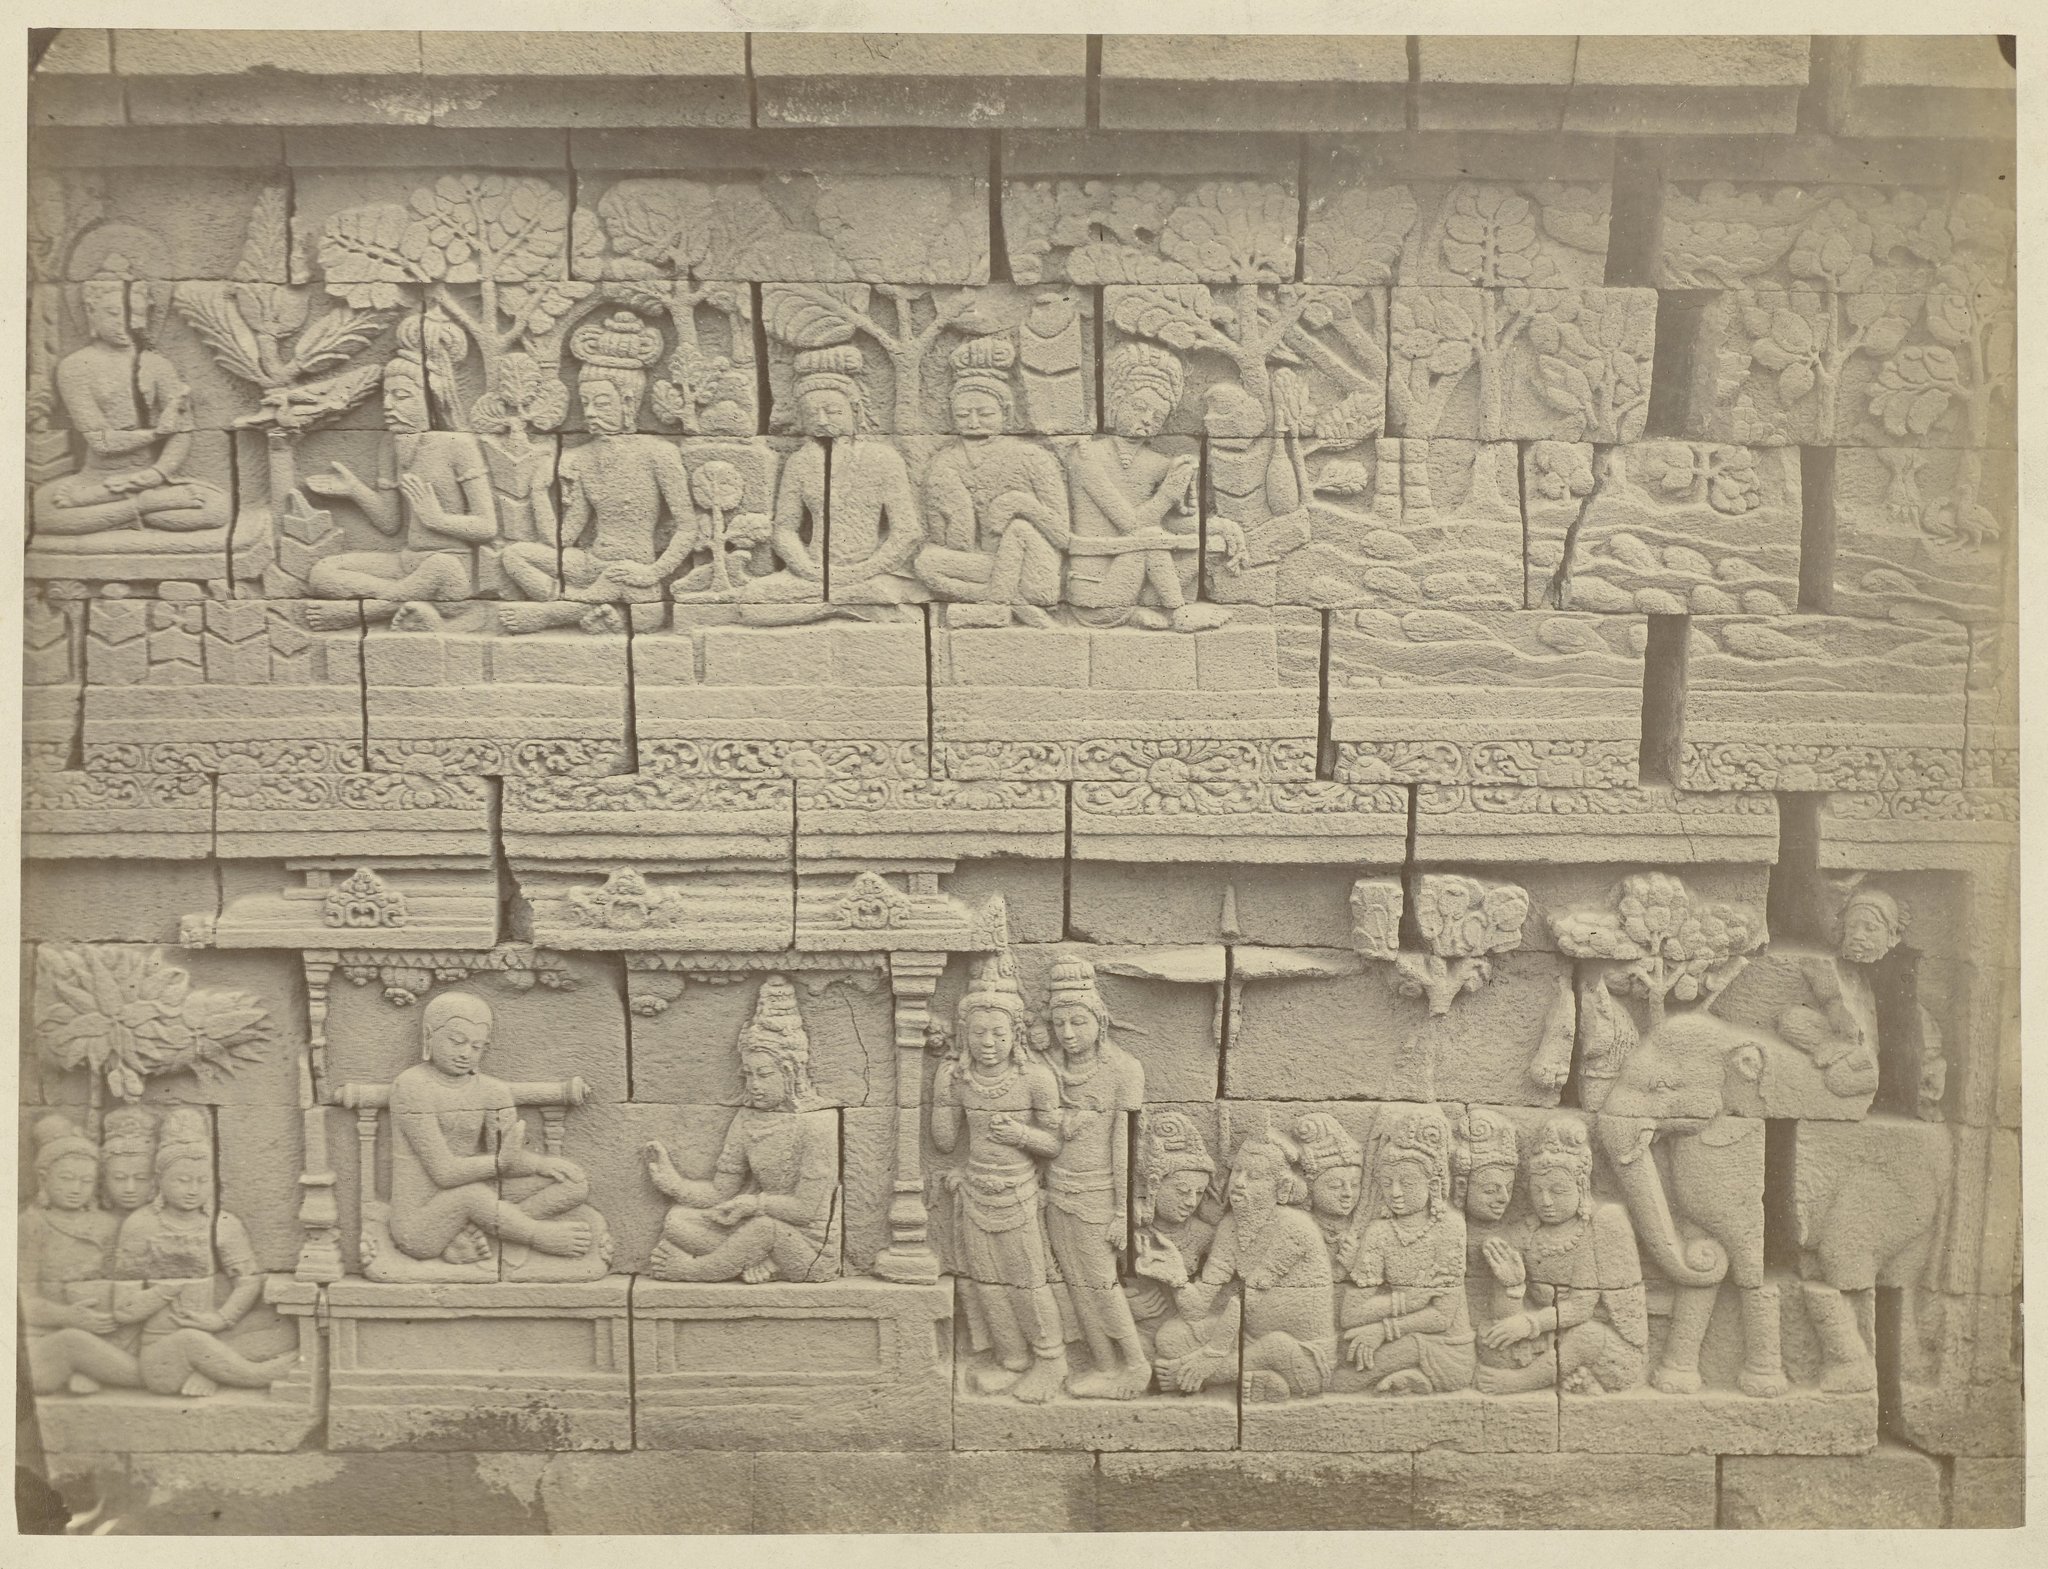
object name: photograph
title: Basreliëf 2e gaanderij.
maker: isidore kinsbergen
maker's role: fotograaf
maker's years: 1821-1905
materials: cardboard, paper, photographic support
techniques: albumen print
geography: java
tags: borobudur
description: Gallery I, main wall, north side 41 (top): relief 1a-78, Lalitavistara relief, Siddharta meditating on the banks of the Naranjana river. 40 bottom: relief 1b-77, Avadana relief, Rudrayana story, Rudrayana, now a monk, meets King Bimbisara. Borobudur village, Magelang district, Central Java province, 778-824 AD.